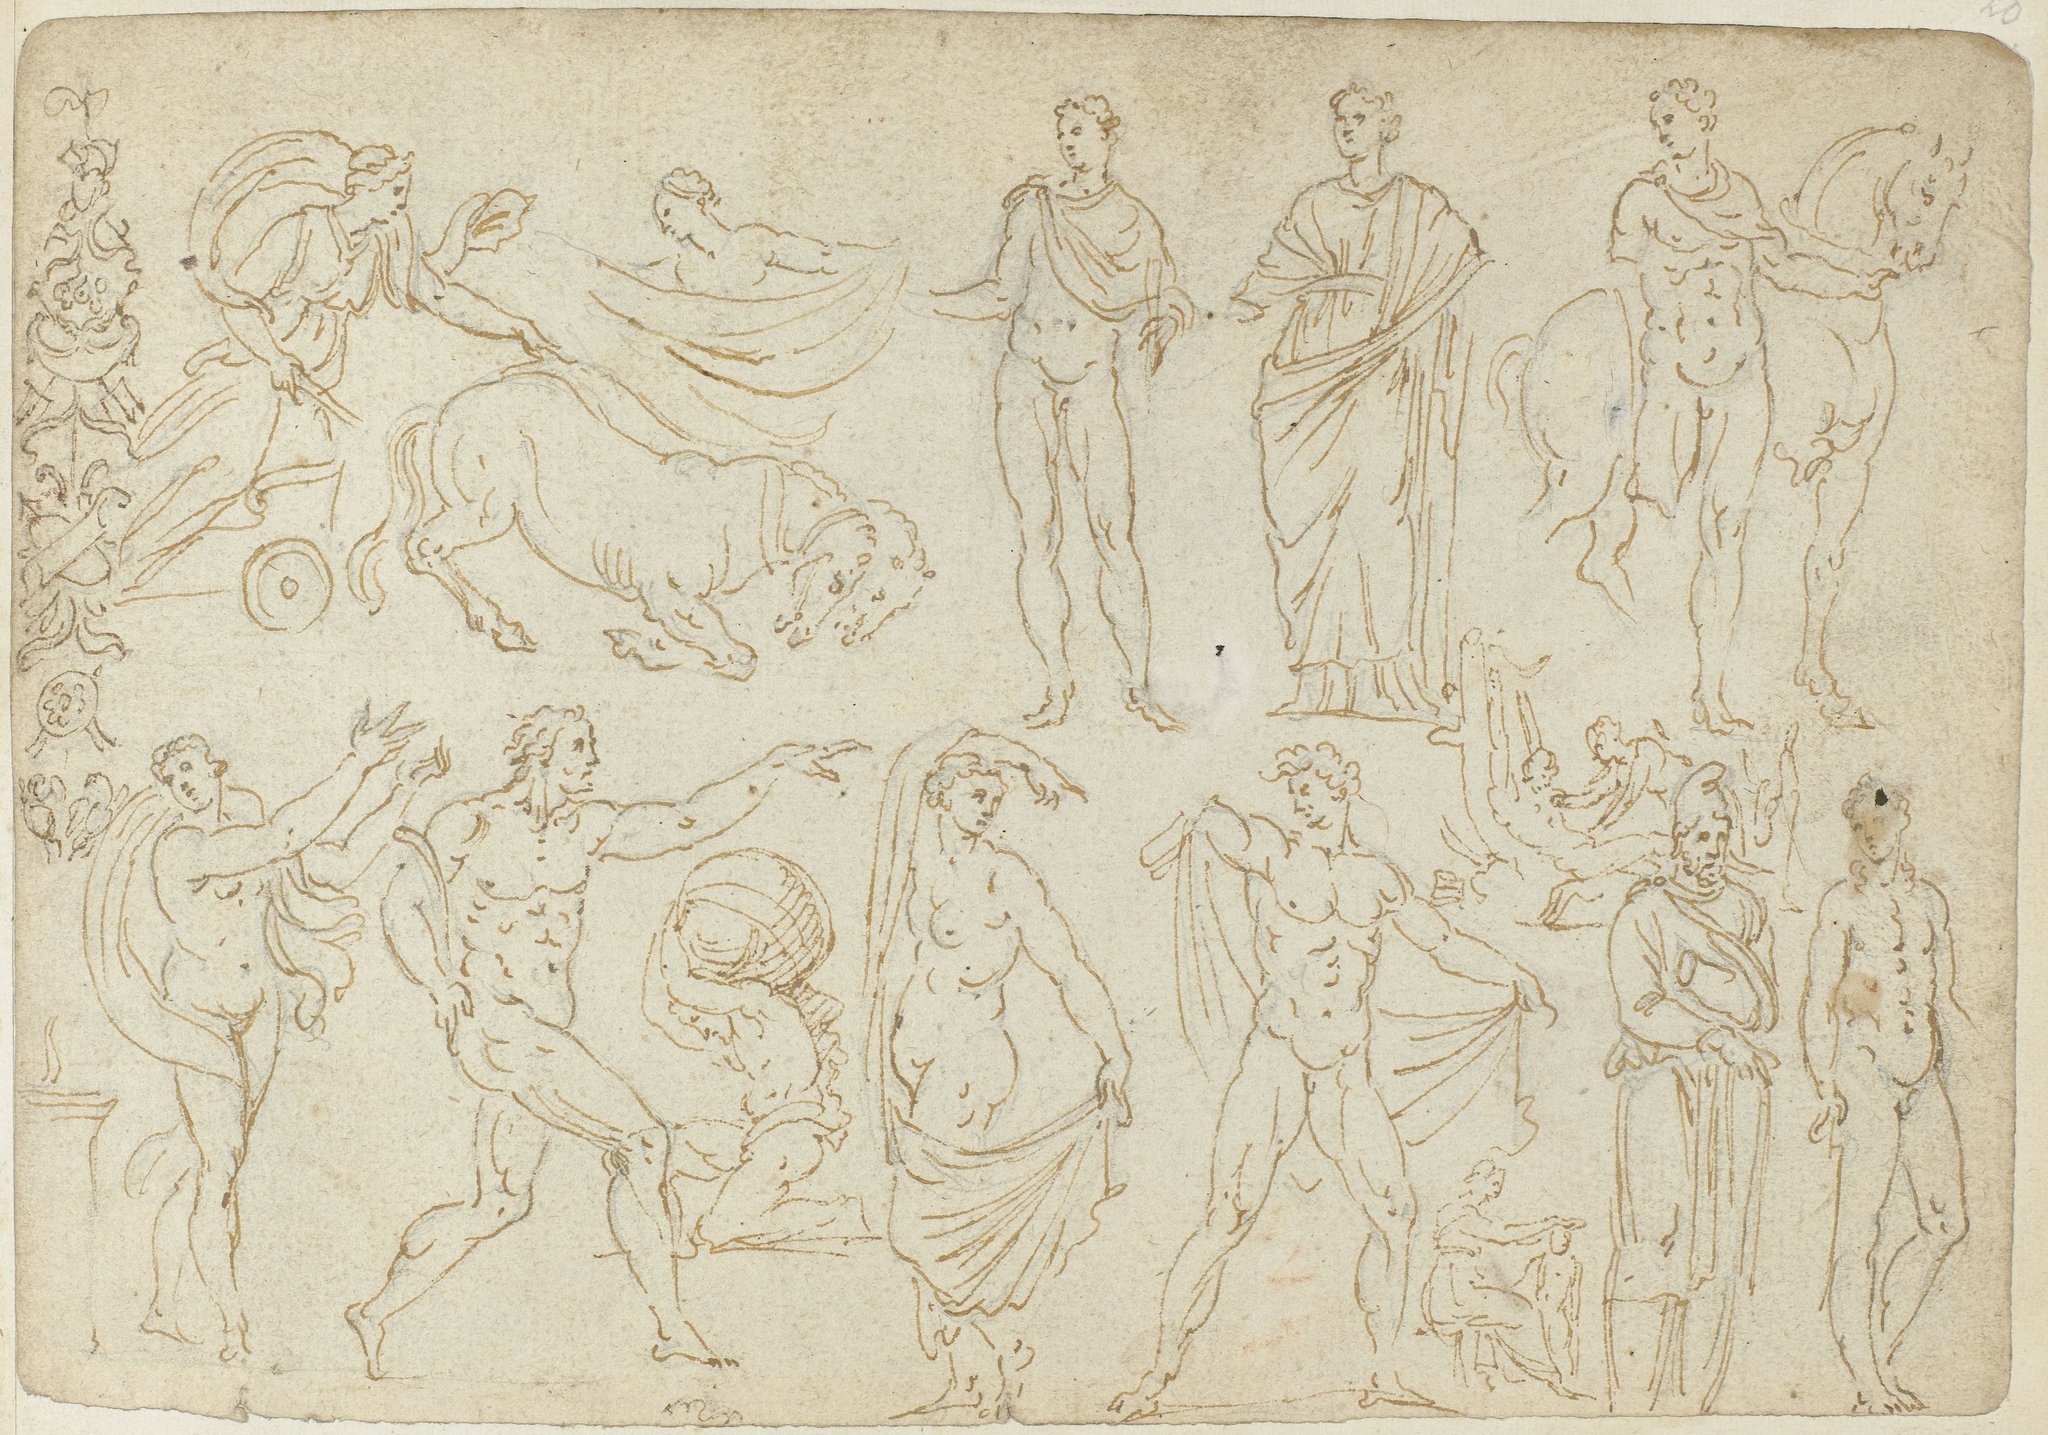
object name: drawing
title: Voorstellingen van sarcofagen en antieke beelden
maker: Anonymous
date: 1550-1570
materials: chalk, ink, paper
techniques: pen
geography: low countries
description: Album "Maarten de Vos schetsboek", blad 5v(12)